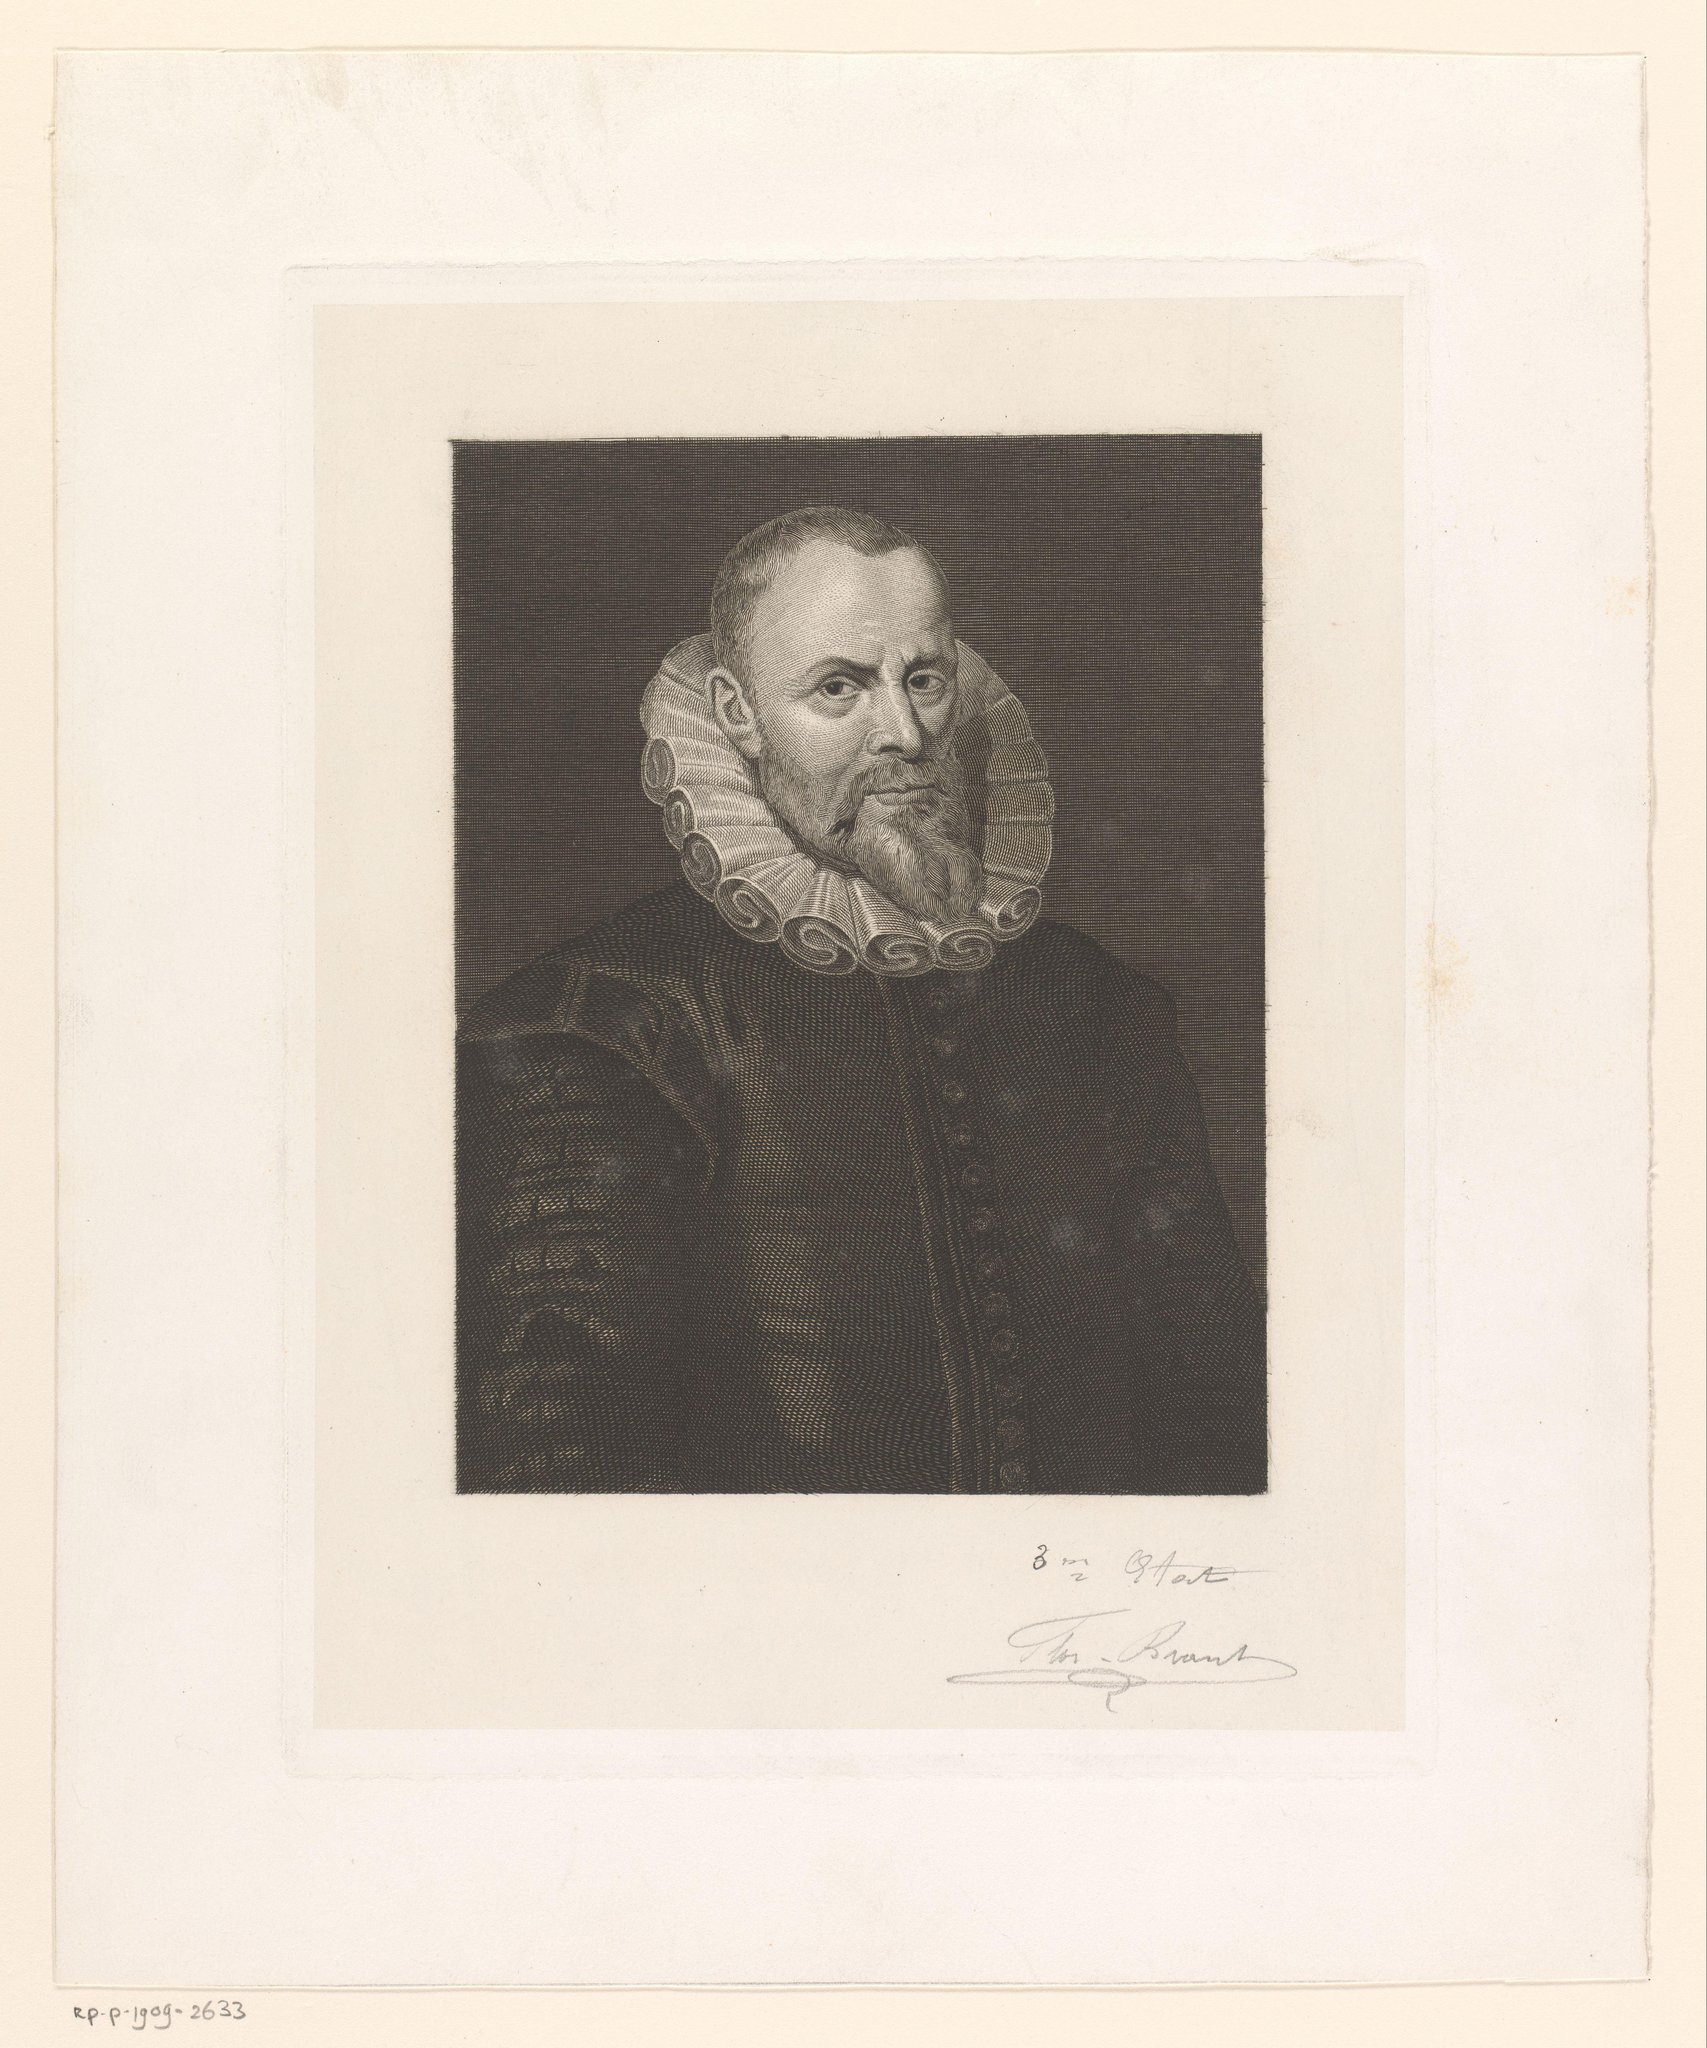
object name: print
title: Portret van een onbekende man met plooikraag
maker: florent brant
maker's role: print maker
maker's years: 1863-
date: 1873-1909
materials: paper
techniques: engraving, etching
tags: adult man, historical persons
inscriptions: inscription: ‘3e Etat’, collector's mark: Lugt 2228